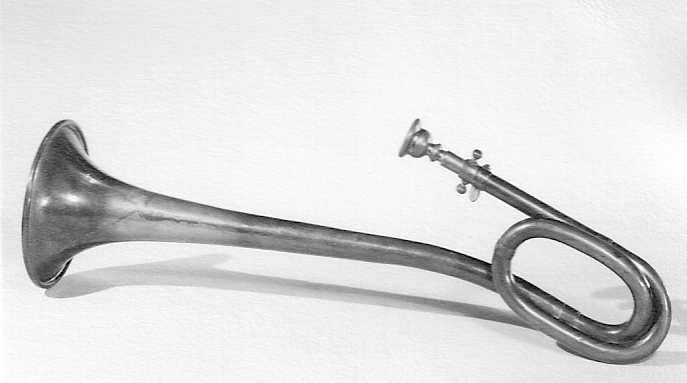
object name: clairon de guerre in e flat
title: Clairon de Guerre in E-flat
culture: french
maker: association générale des ouvriers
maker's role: maker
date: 1867-1900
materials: brass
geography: france